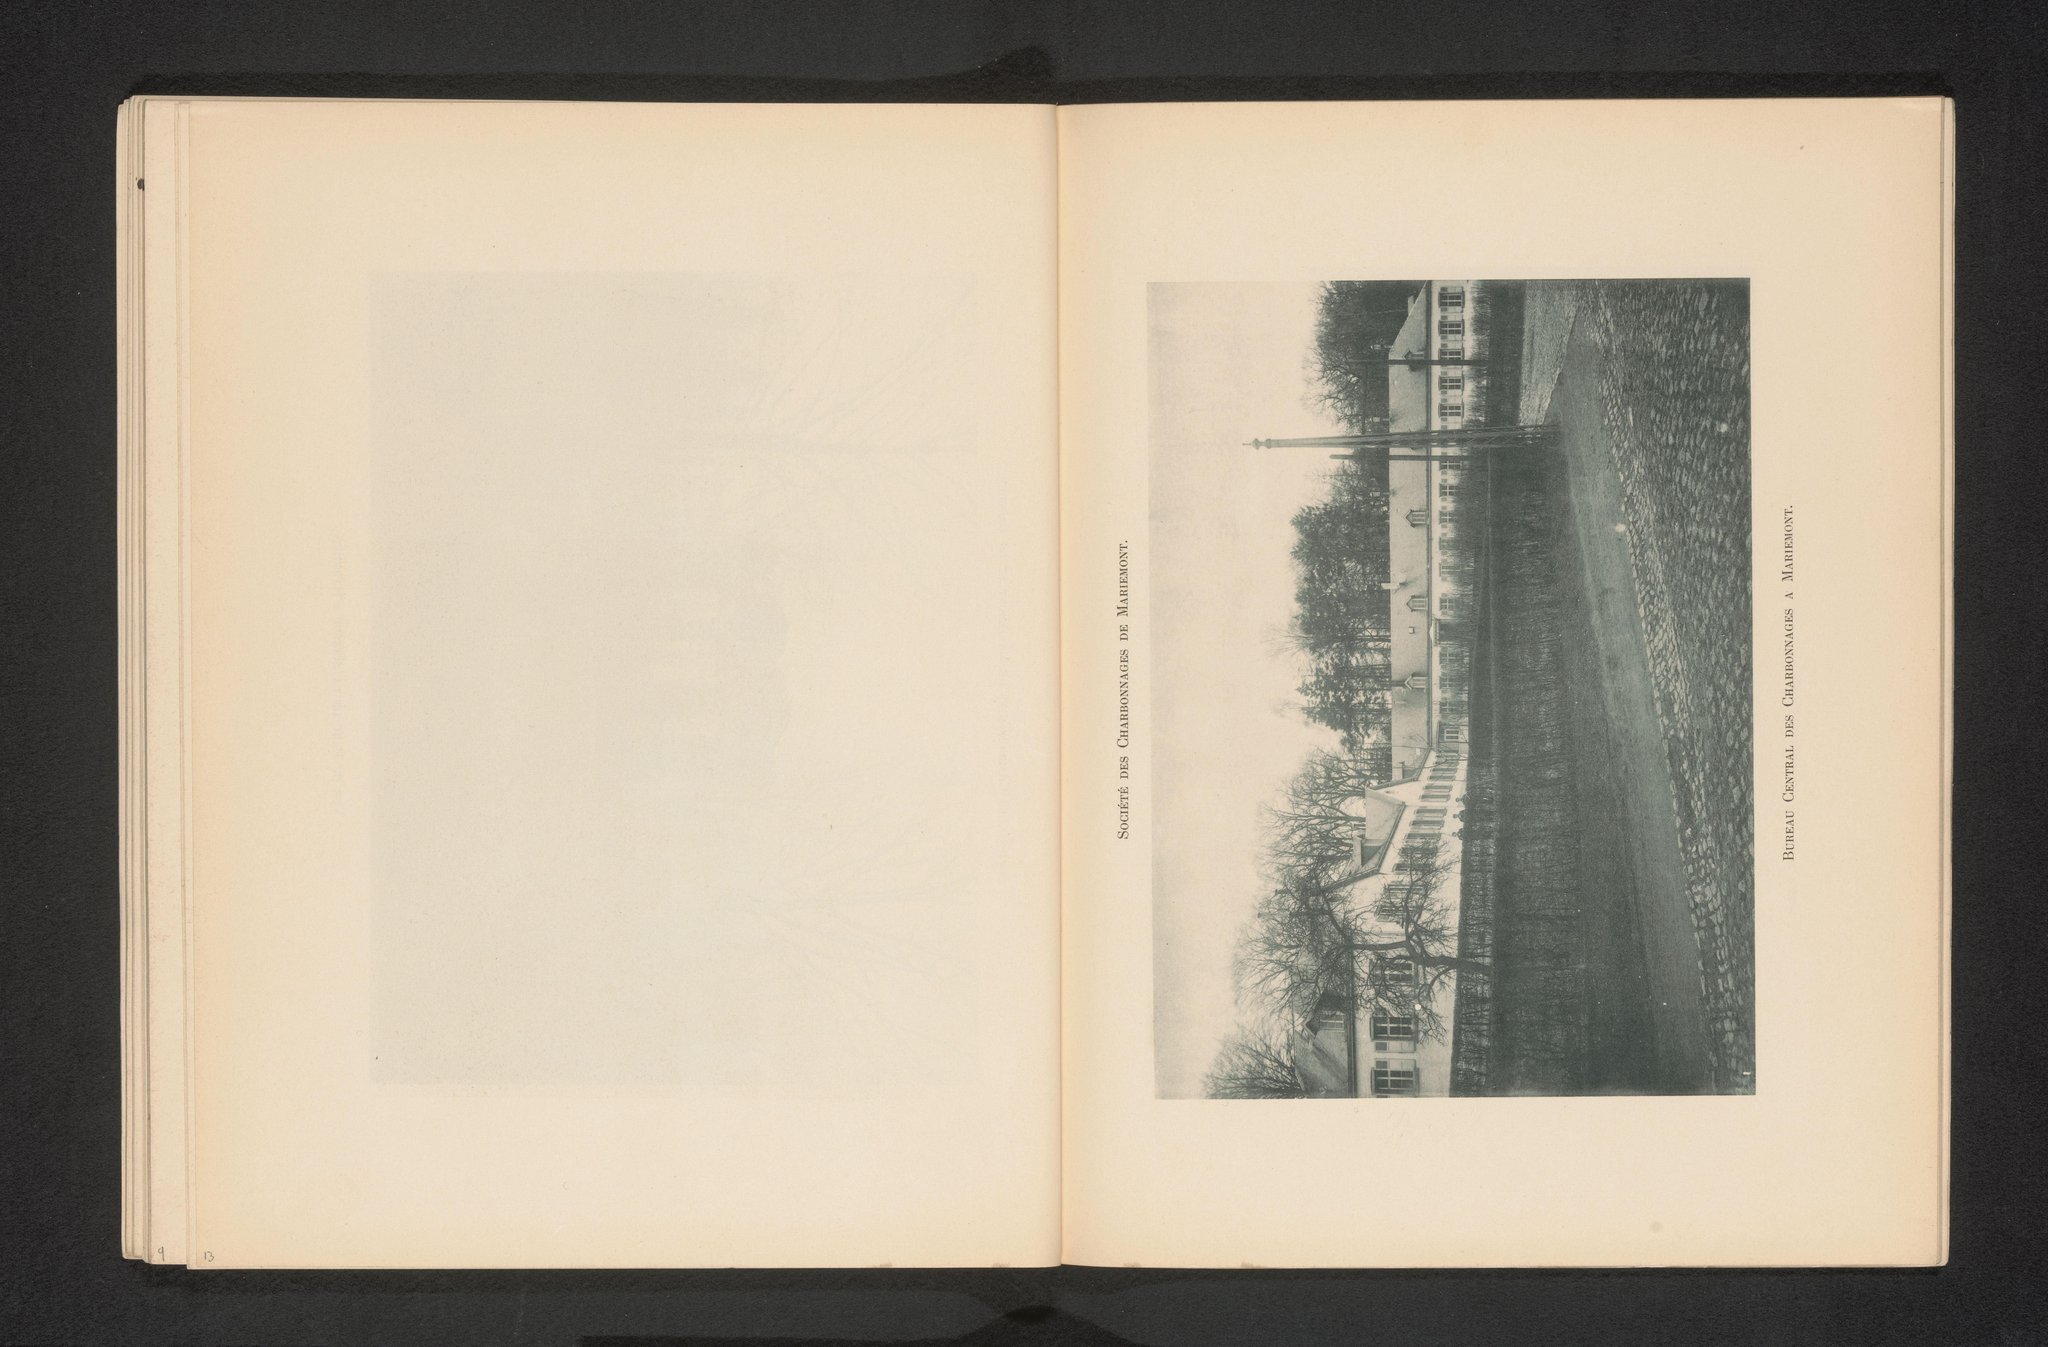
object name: page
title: Bureau Central des Charbonnages a Mariemont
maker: Anonymous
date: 1895-1900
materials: paper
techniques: photograph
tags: façade (of house or building)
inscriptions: inscription: ‘Société des Charbonnages de Mariemont’